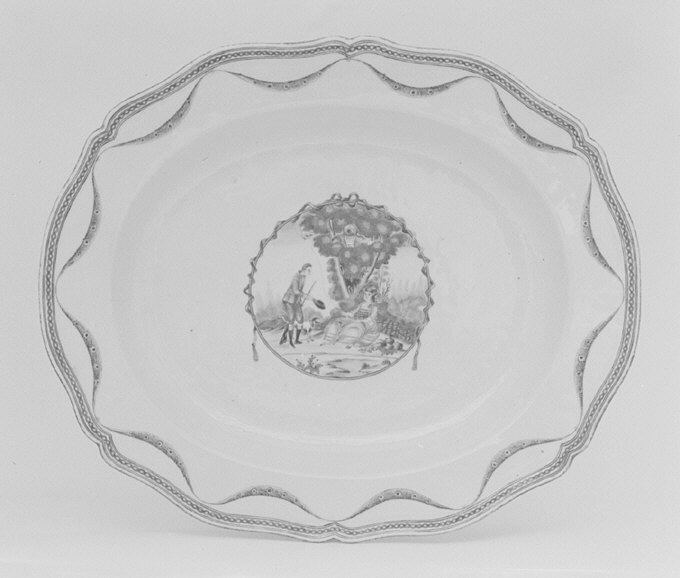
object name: platter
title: Platter (part of a service)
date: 1750-1770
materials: hard paste porcelain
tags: men,women